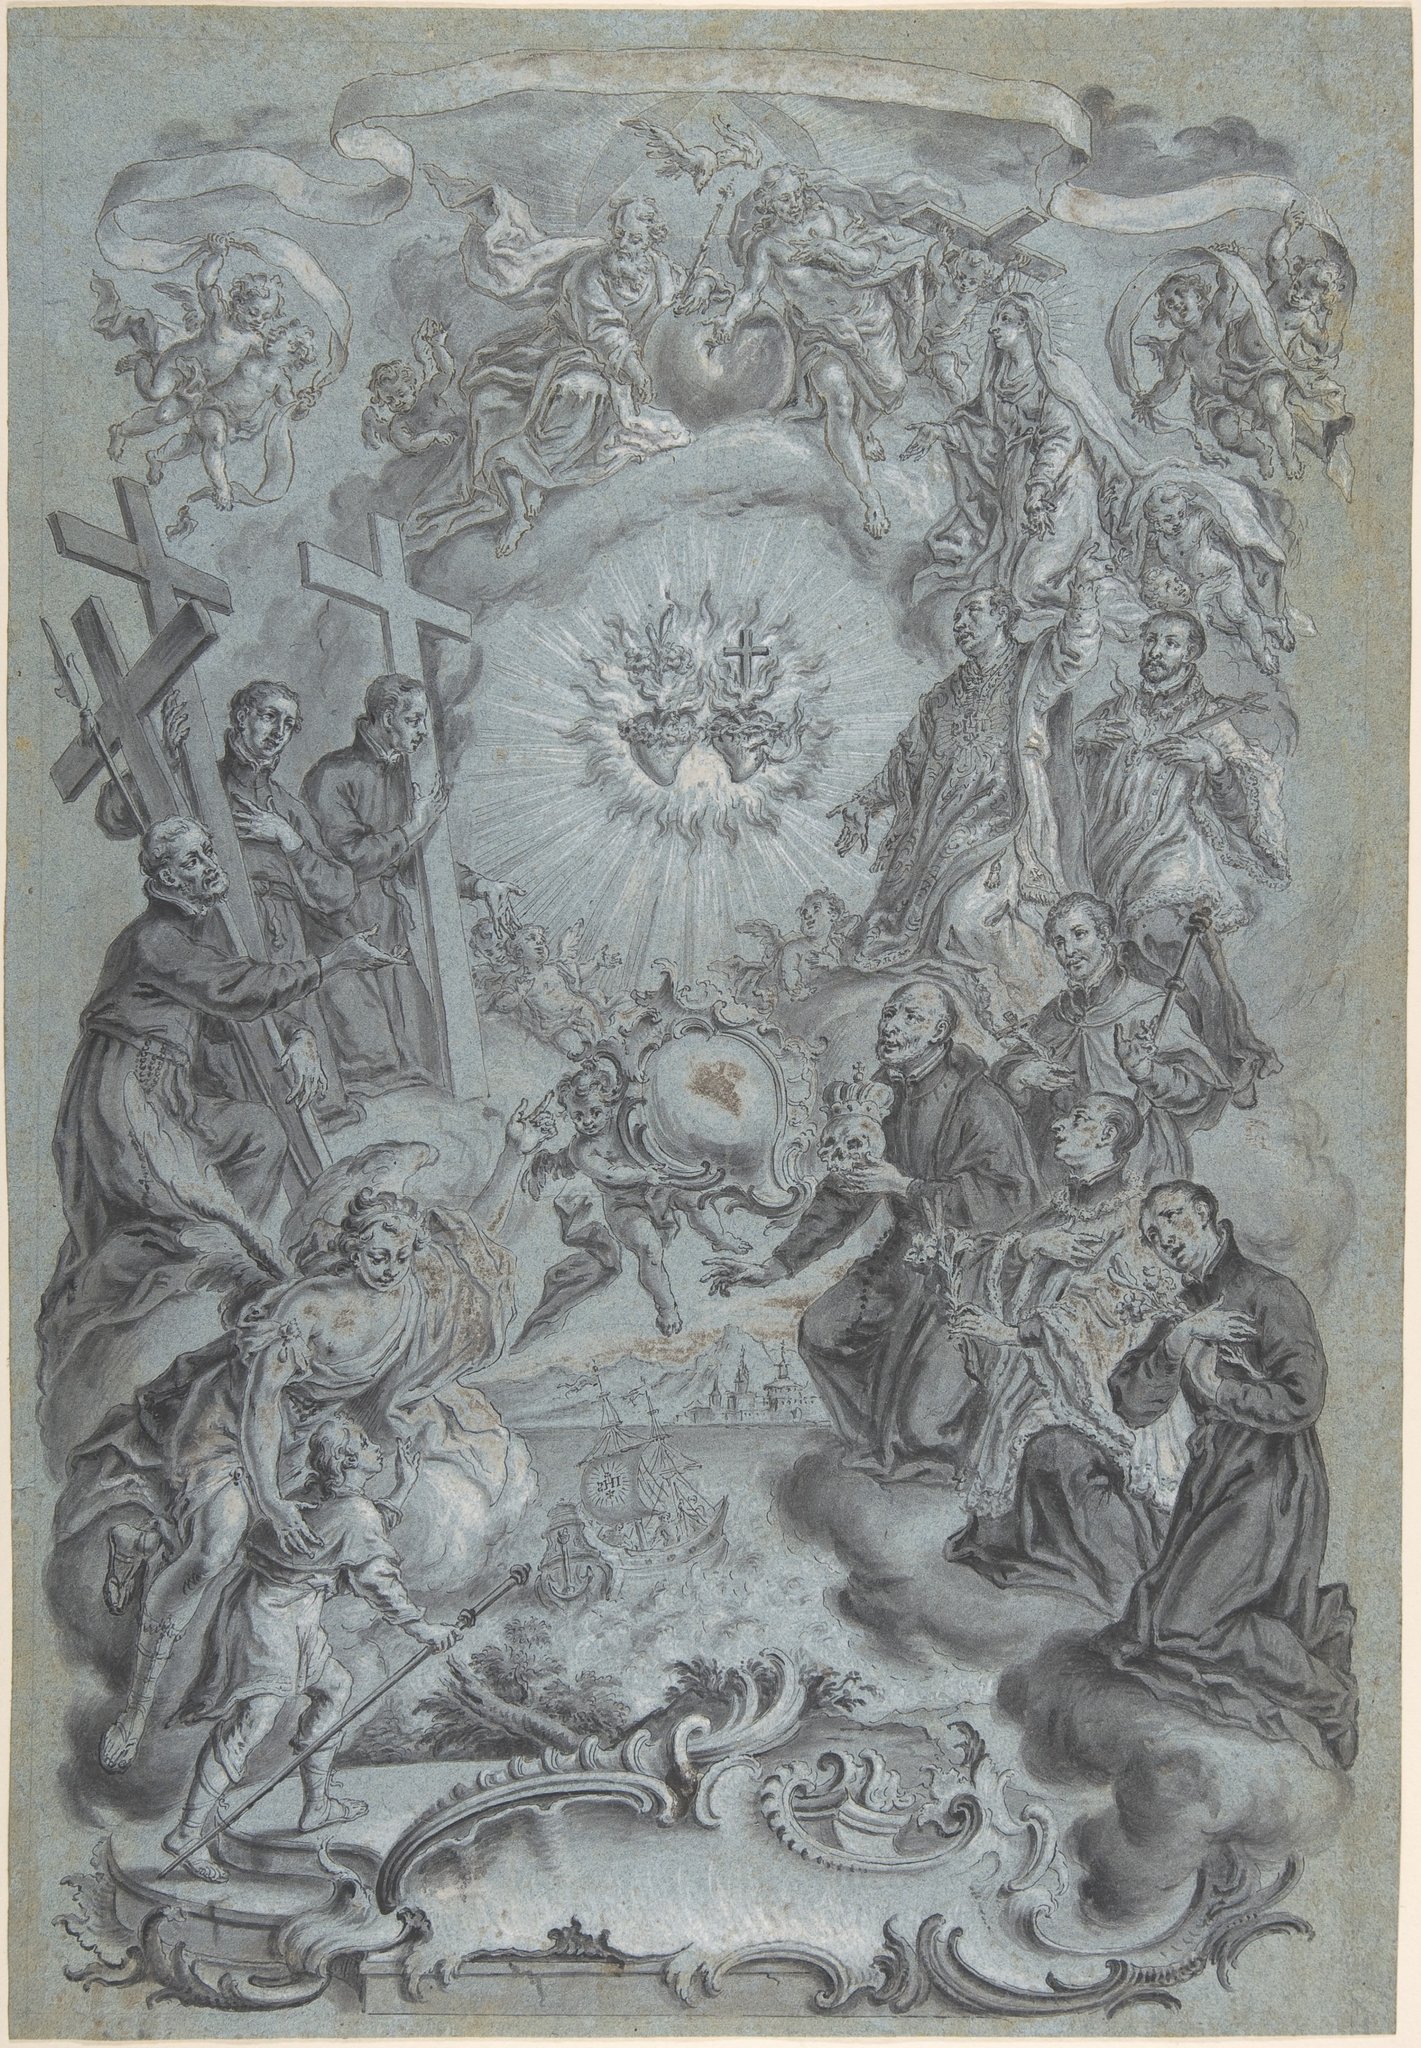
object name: drawing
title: A Study for a Frontispiece: The Trinity and Saints surrounding the Sacred Hearts of Christ and the Virgin Mary, a Coastal Landscape Below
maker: vitus felix rigl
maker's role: artist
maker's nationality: german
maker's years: 1743-1779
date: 1743-1779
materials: chalk, ink, lead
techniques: brush, highlighting, pen, wash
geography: germany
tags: cross,saints,ships